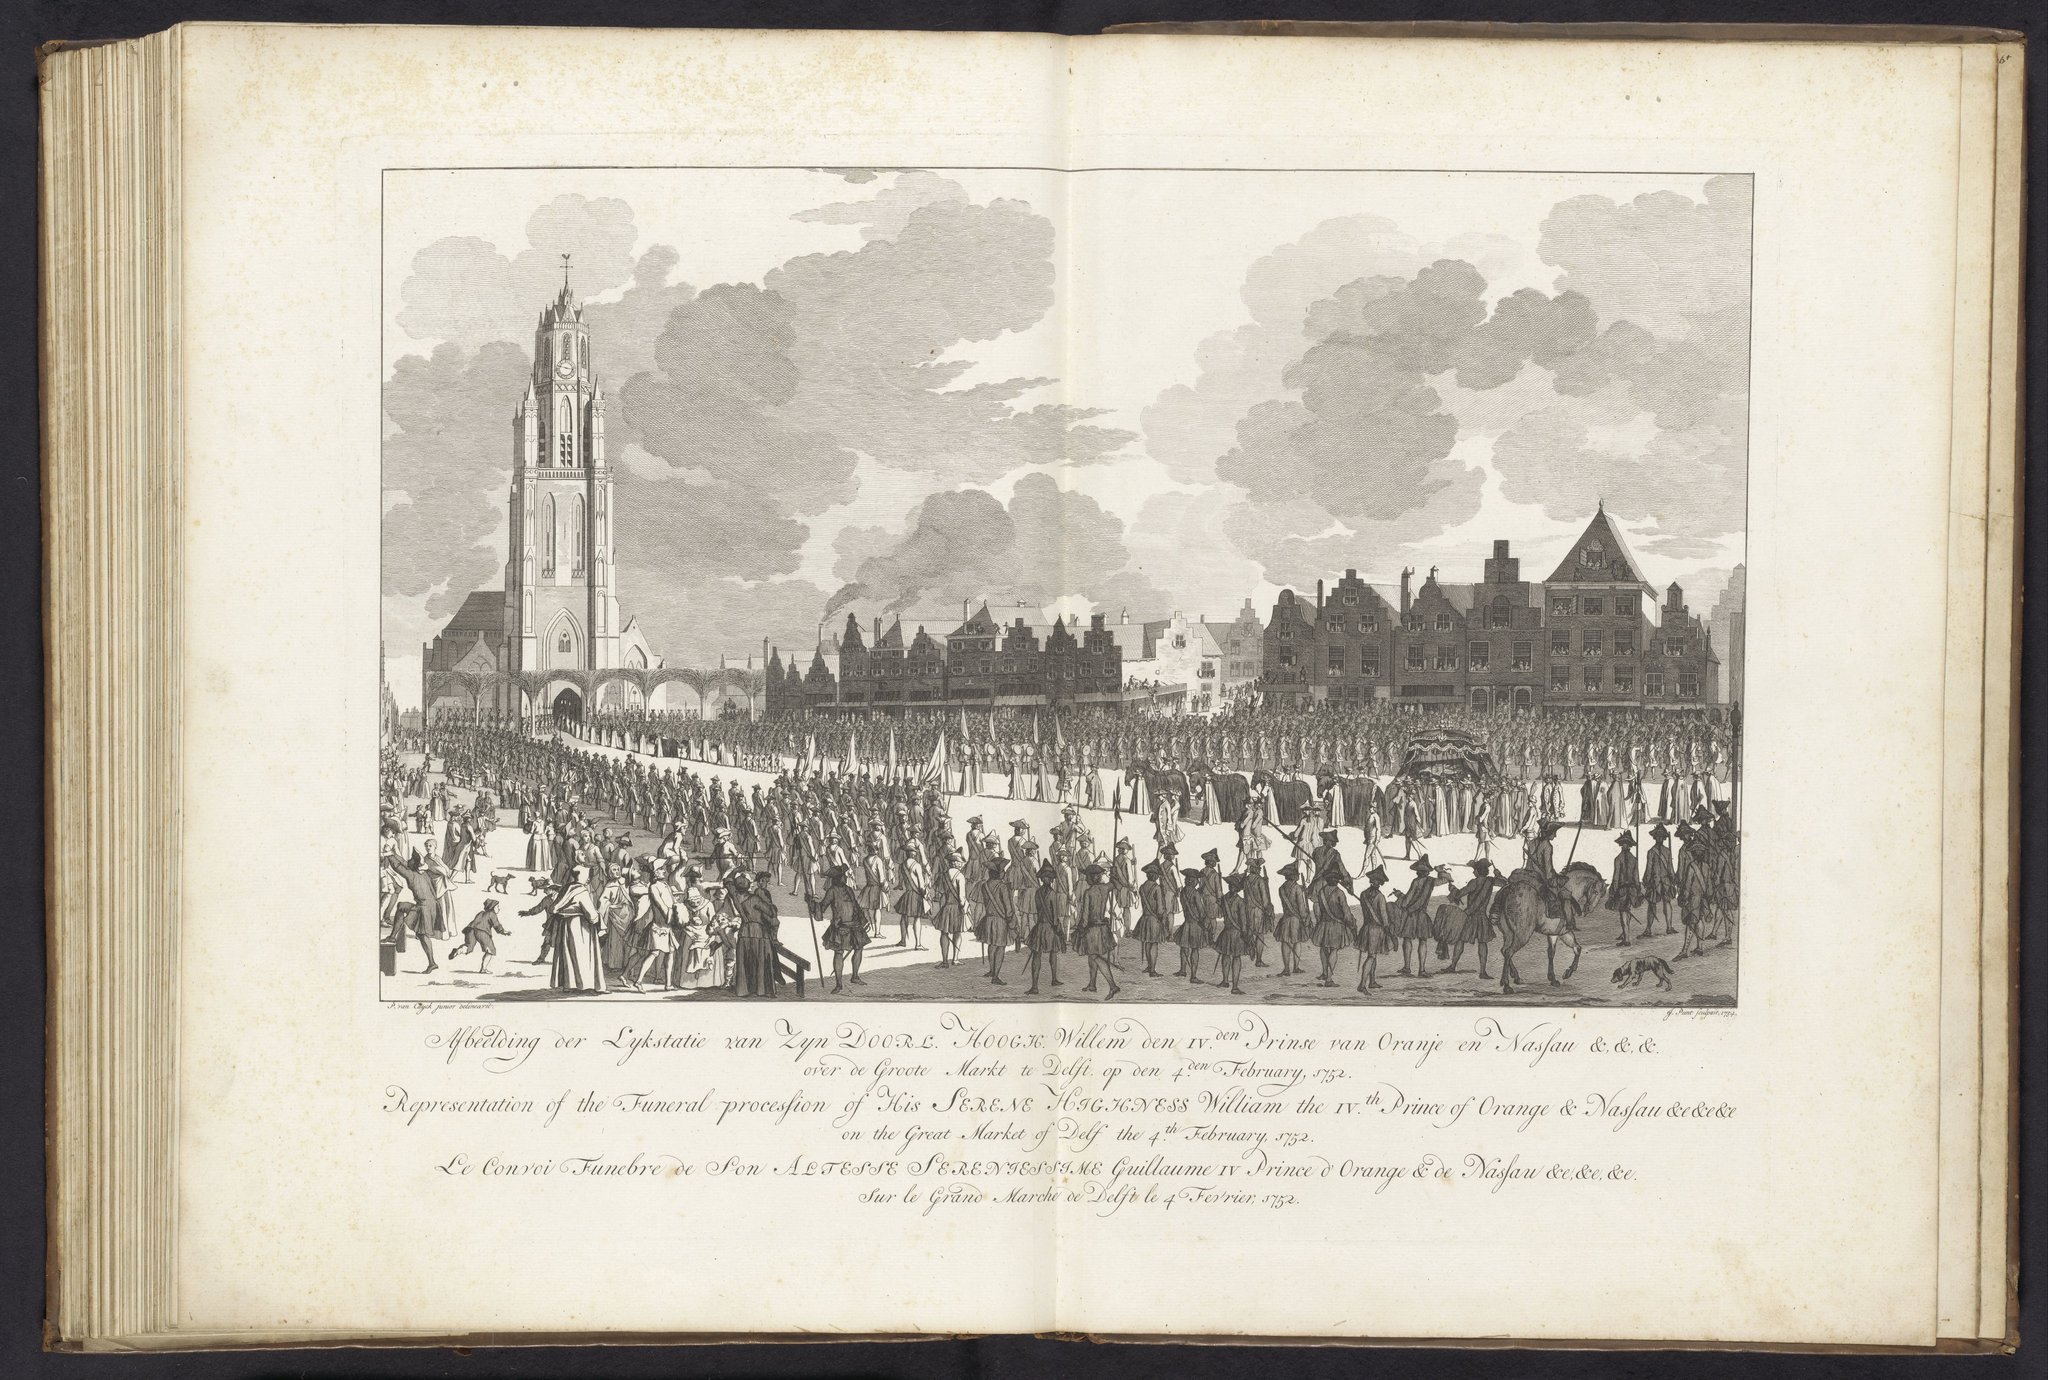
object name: print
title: Lyk-staetsie van zyne doorluchtigste Hoogheid den Heere Willem [IV] Carel Hendrik Friso, Prince van Orange en Nassau (...) gehouden den IV Februari 1752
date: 1754-1755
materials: paper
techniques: engraving, etching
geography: the hague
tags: the hague, willem iv (prins van oranje-nassau), cortege, funeral procession, delft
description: Aankomst van de rouwstoet met de lijkwagen op de Grote Markt te Delft en de intocht in de Nieuwe Kerk. In de marge het onderschrift in Nederlands, Frans en Engels. Onderdeel van een serie van 41 platen van de begrafenisstoet van stadhouder Willem IV te Delft op 4 februari 1752. Ongenummerd. In de gebonden uitgave van 1755.